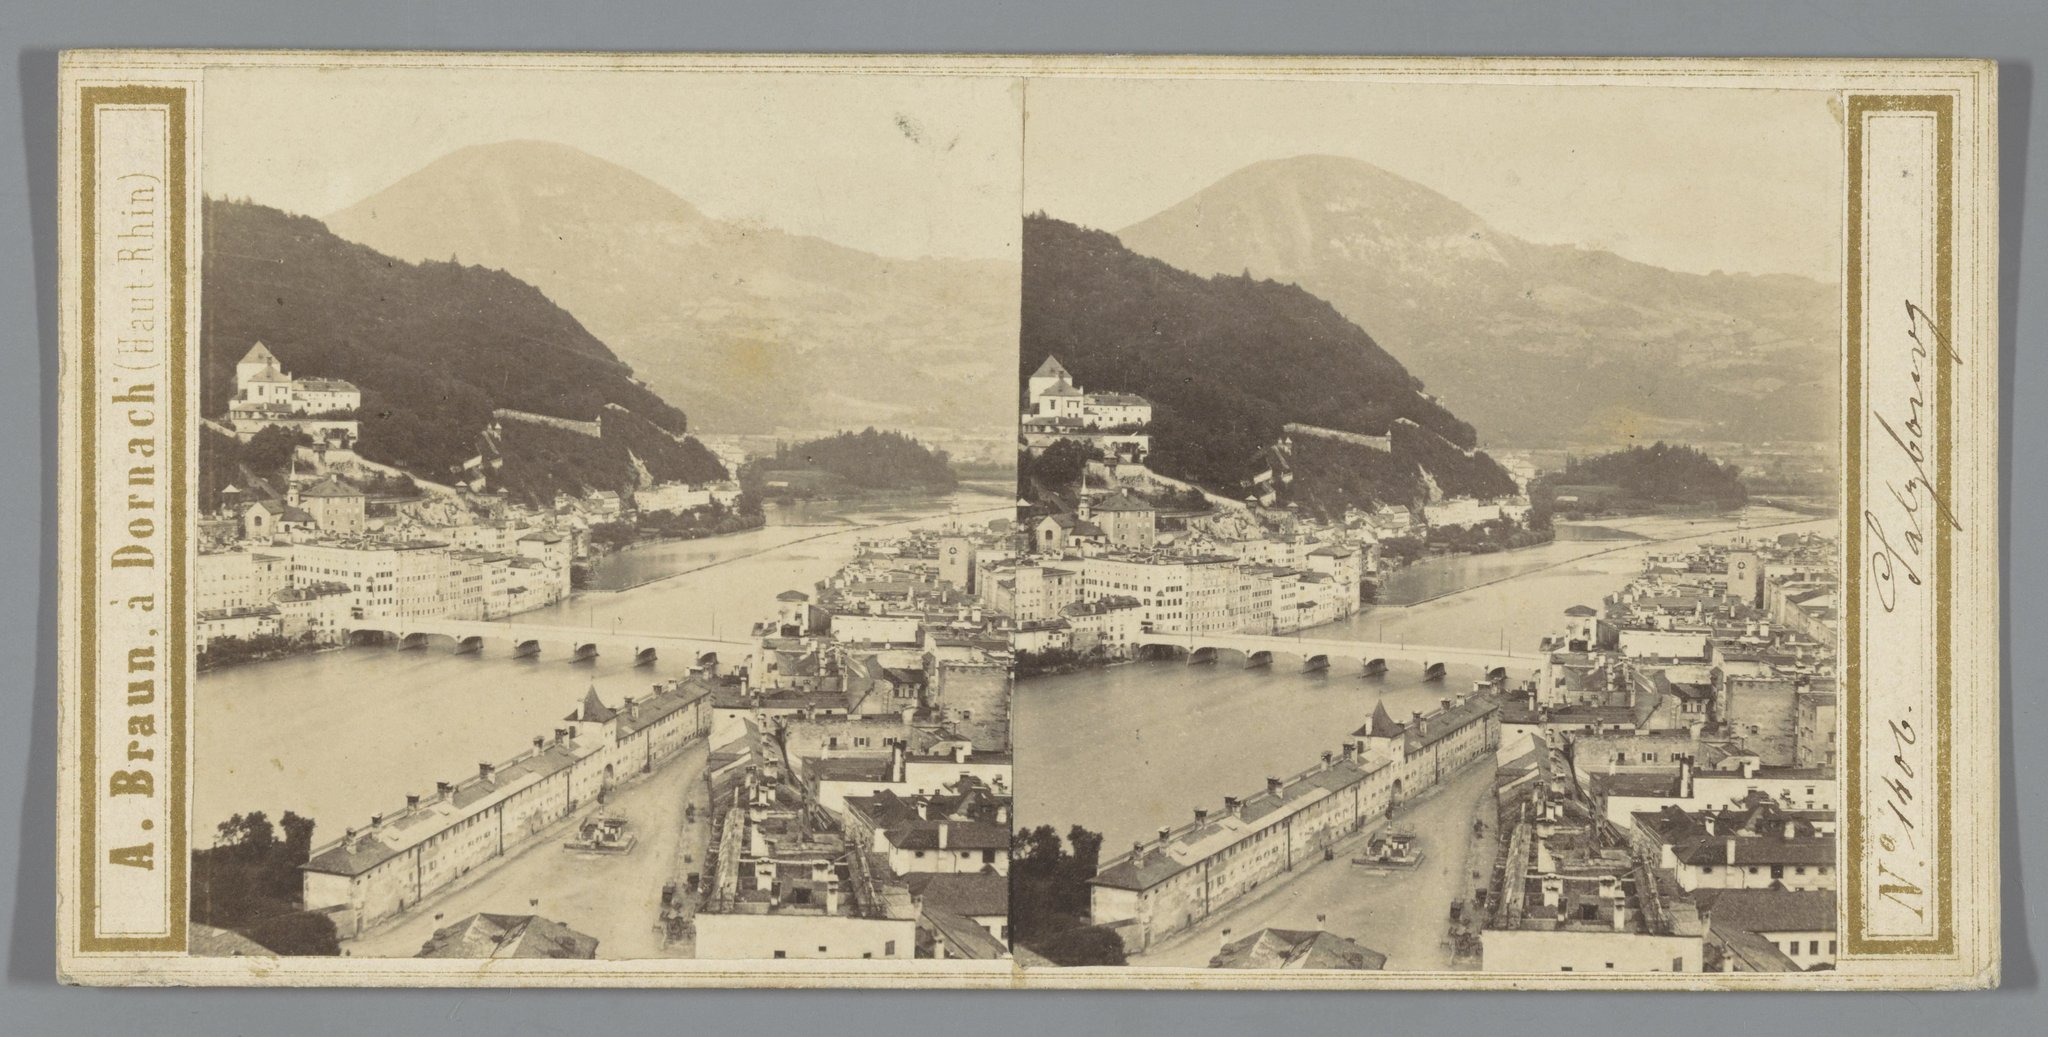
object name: stereograph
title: Gezicht op de Salzach door Salzburg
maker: Anonymous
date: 1860-1866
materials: cardboard, paper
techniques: albumen print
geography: austria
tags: city-view in general; 'veduta', river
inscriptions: number: ‘No. 1406.’